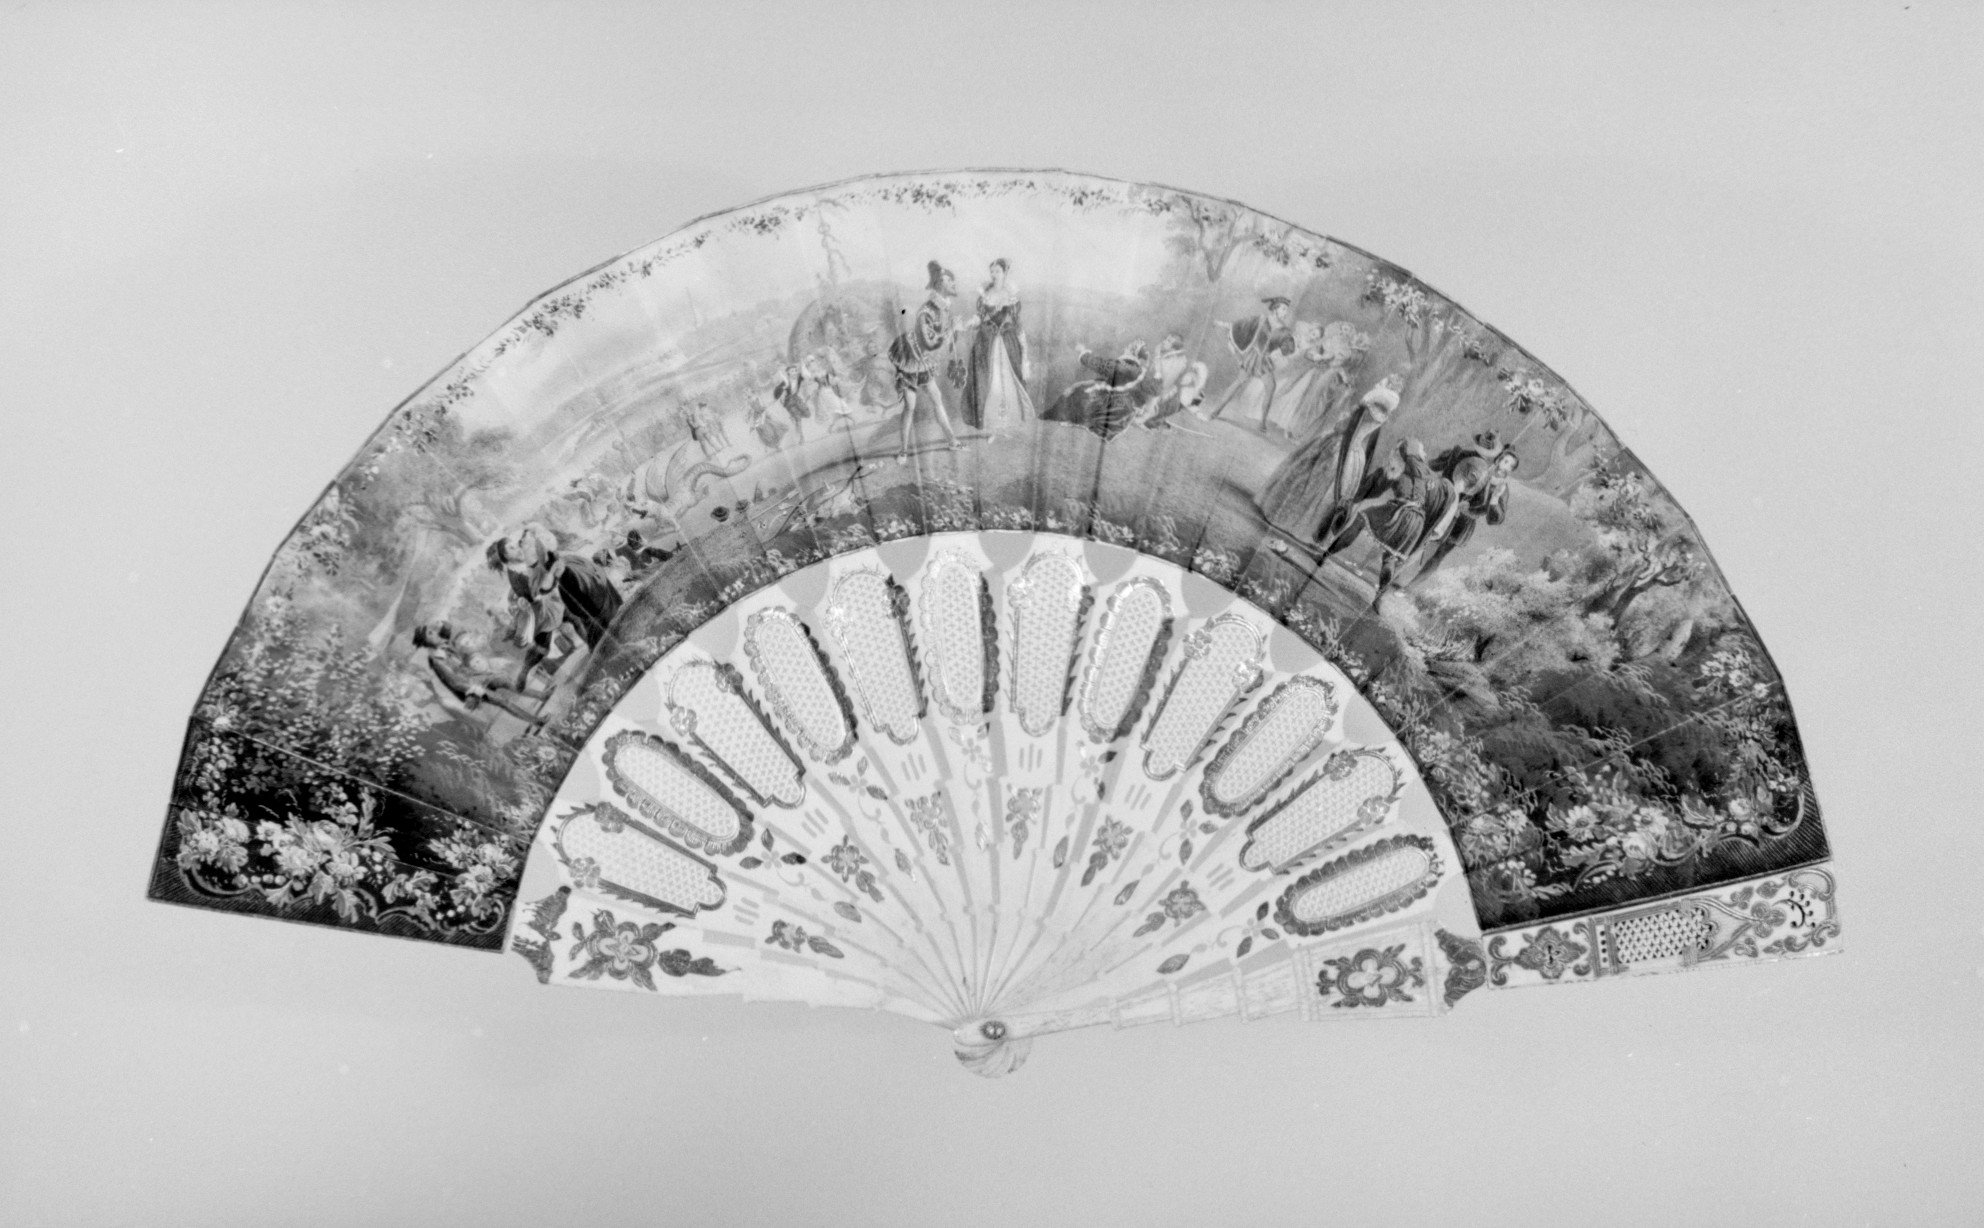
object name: fan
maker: palamède de visconty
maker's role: designer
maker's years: 1800-1900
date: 1834-1866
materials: glass, gold, ivory, paint, paper, silver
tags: men,women